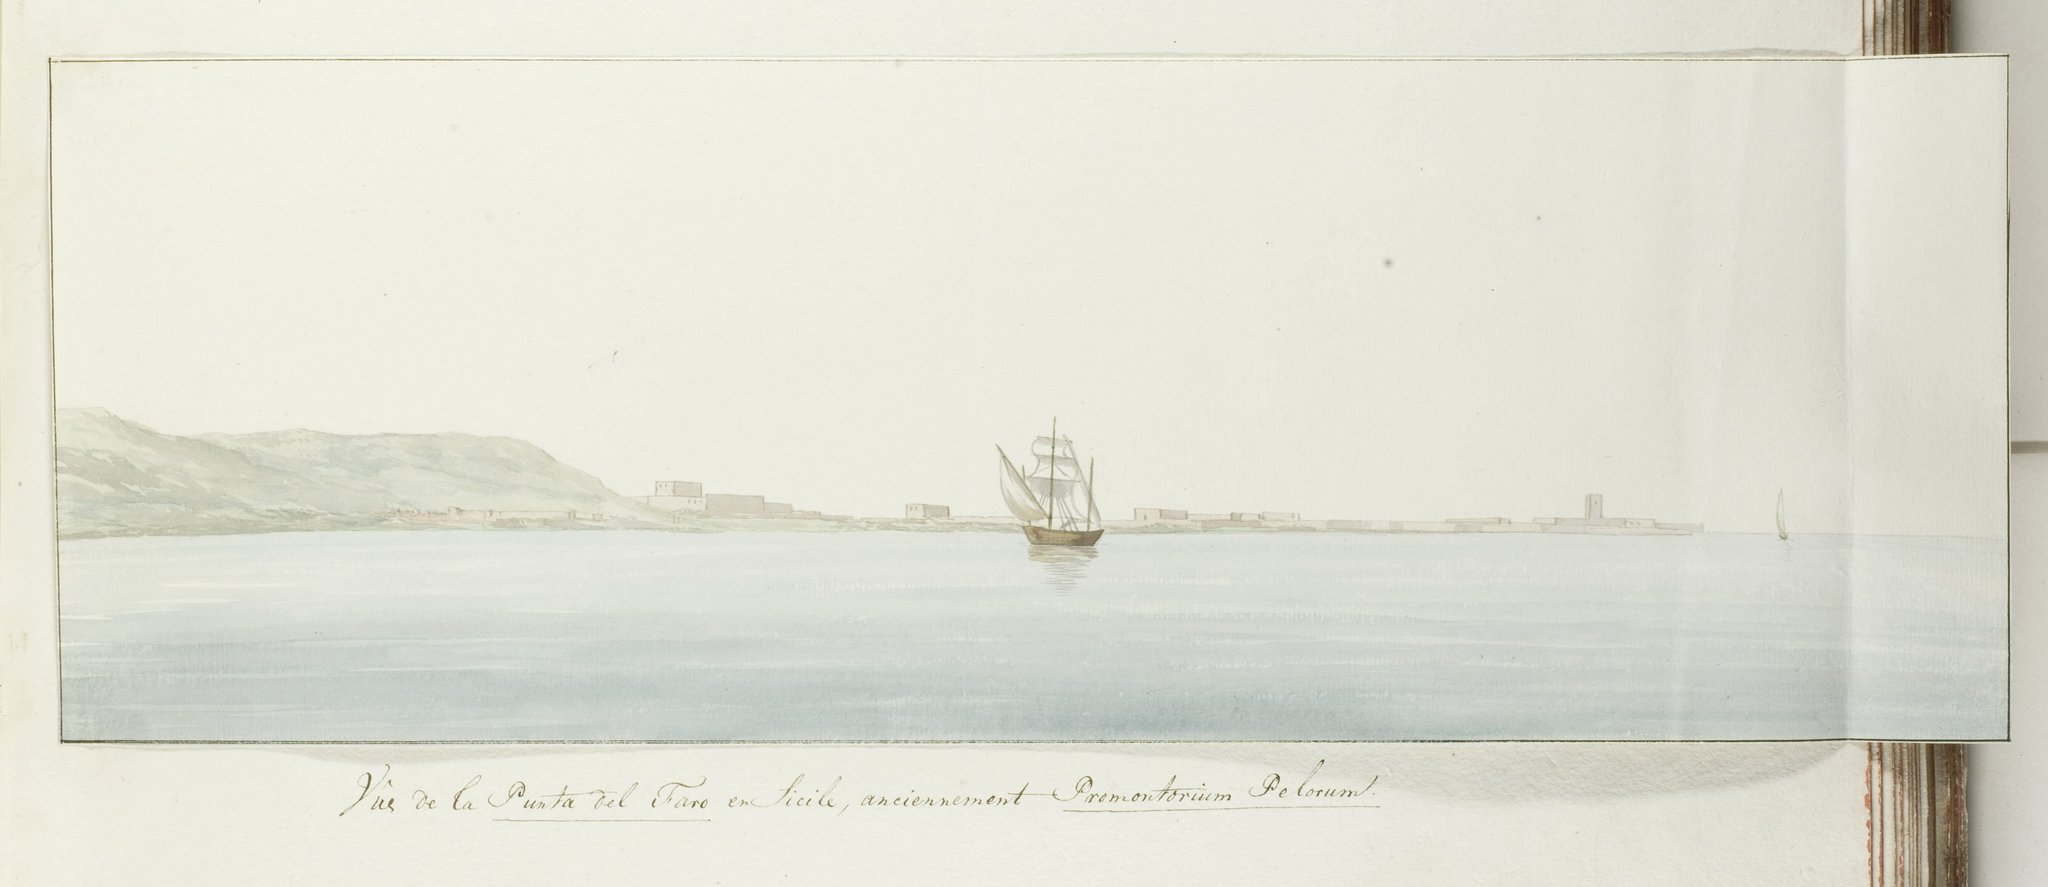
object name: drawing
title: Vue de la Punta del Faro en Sicile, anciennement Promontorium Pelorum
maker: louis ducros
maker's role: draughtsman, print maker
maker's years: 1748-1810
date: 1778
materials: paper, watercolor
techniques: brush, pen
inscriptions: number: ‘No 143 Vue de la Punta del Faro en Sicile, anciennement Promontorium Pelorum’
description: Tekening uit het album 'Voyage en Italie, en Sicile et à Malte', 1778.